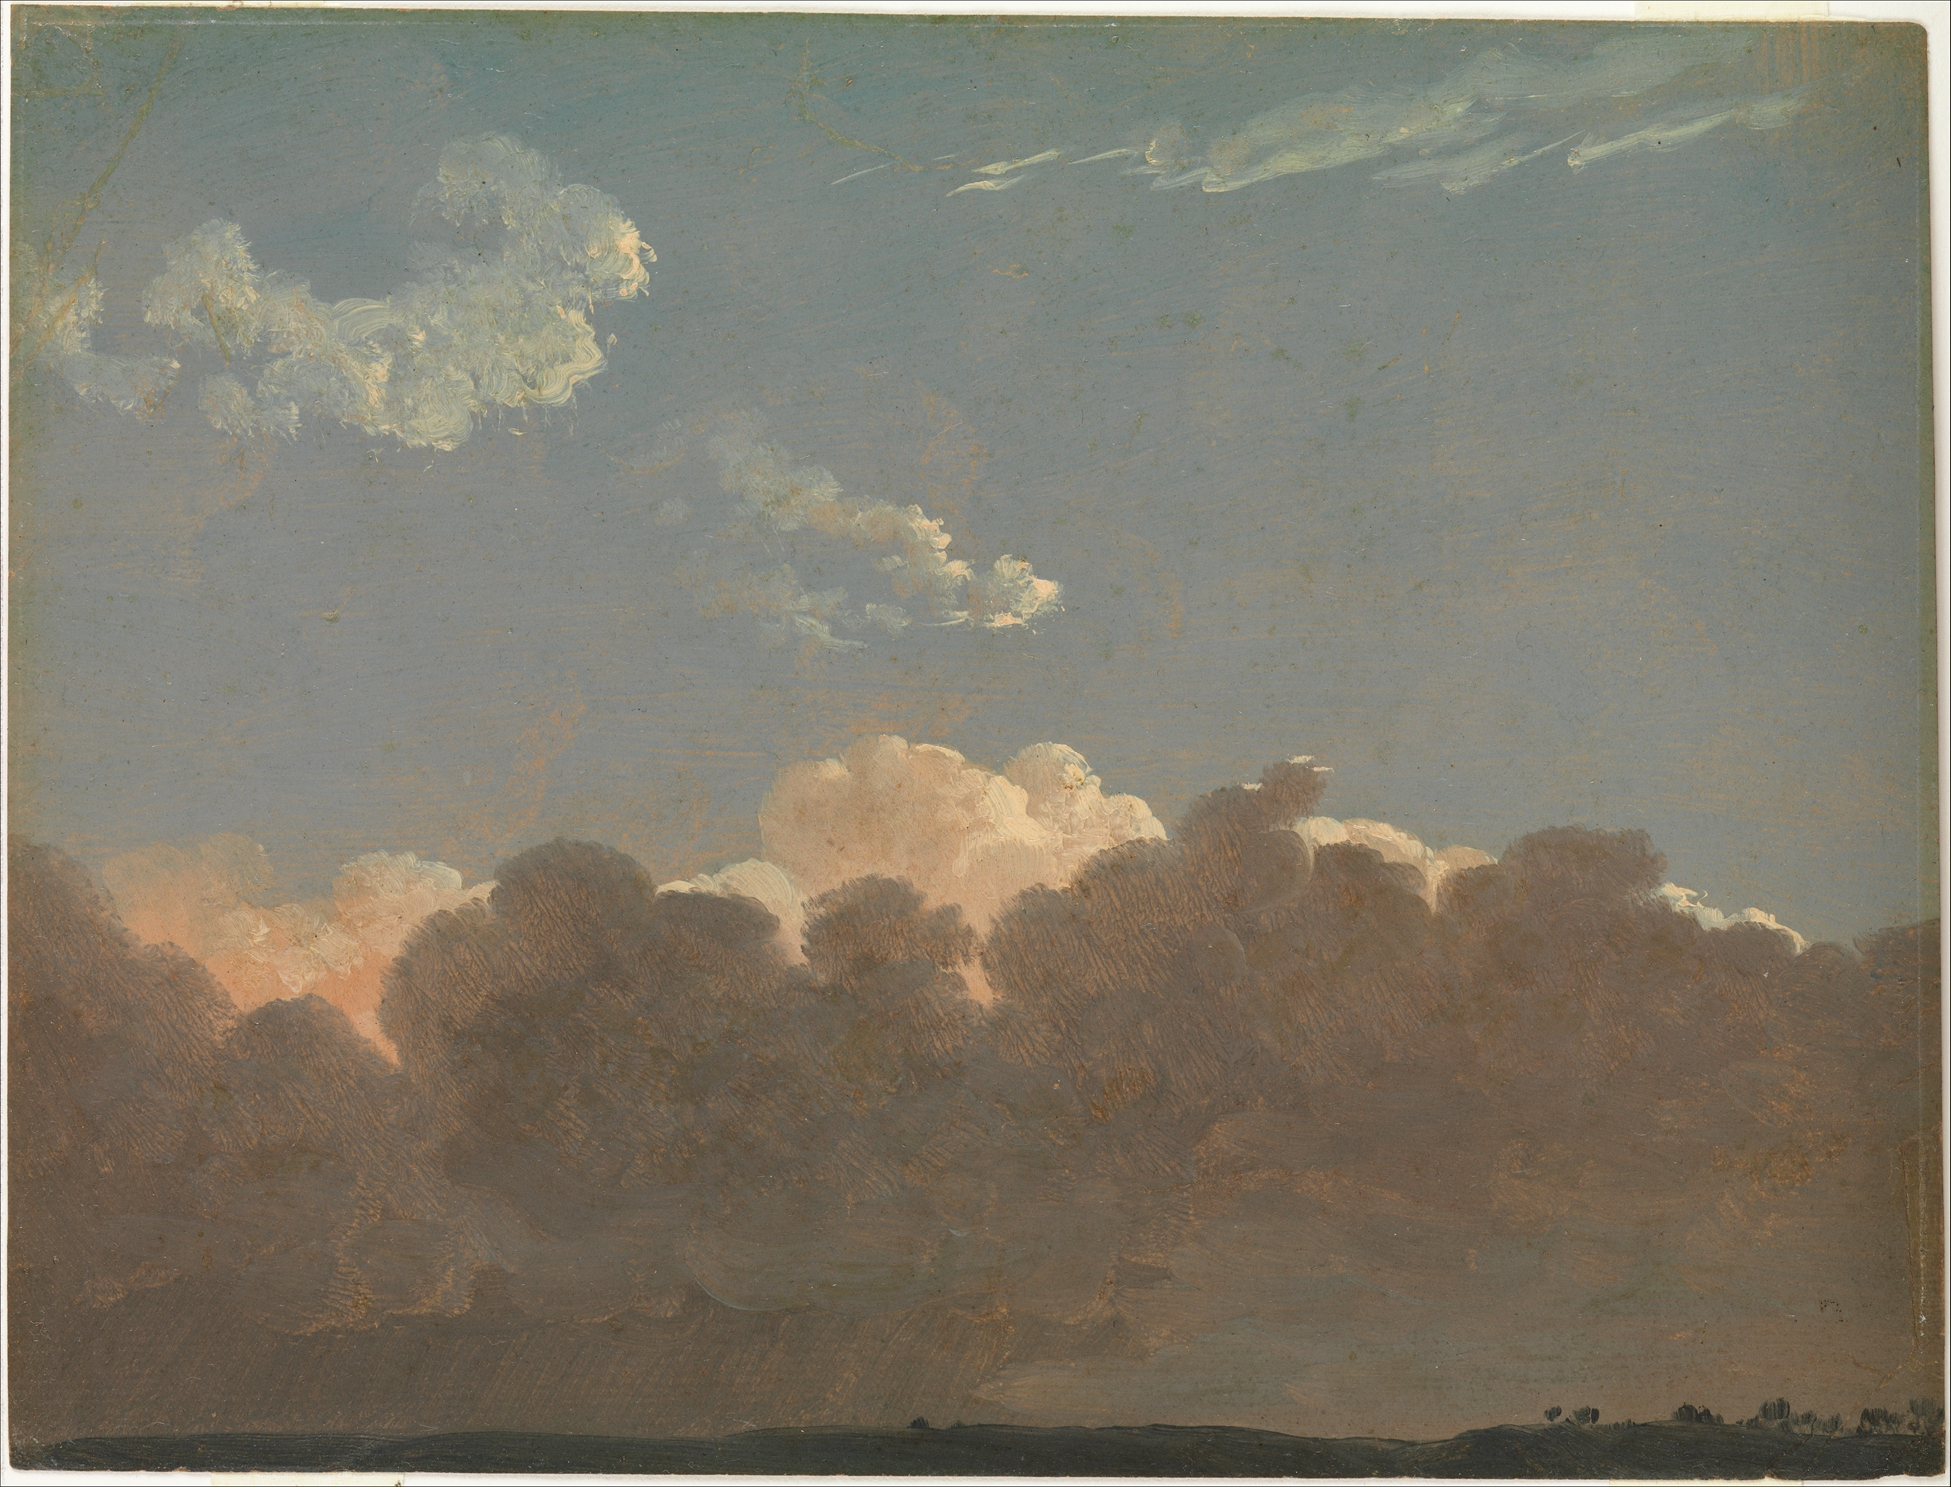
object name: painting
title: Cloud Study (Distant Storm)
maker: simon denis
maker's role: artist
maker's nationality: flemish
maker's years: 1755-1813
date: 1786-1806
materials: oil, paper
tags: sky,clouds